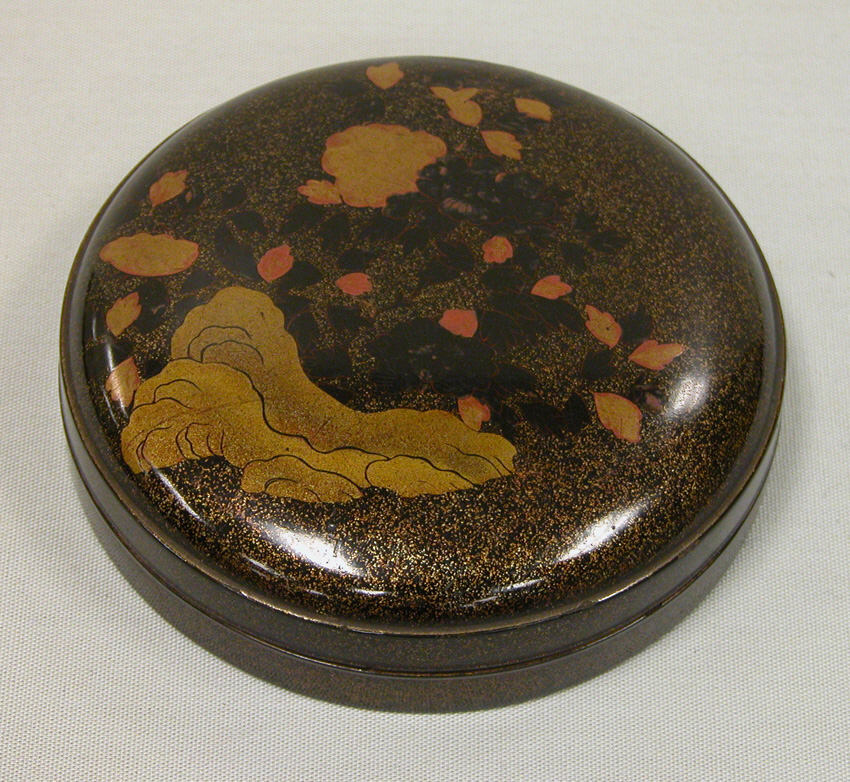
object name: box with cover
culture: japanese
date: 1767-1800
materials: gold, lacquer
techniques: maki